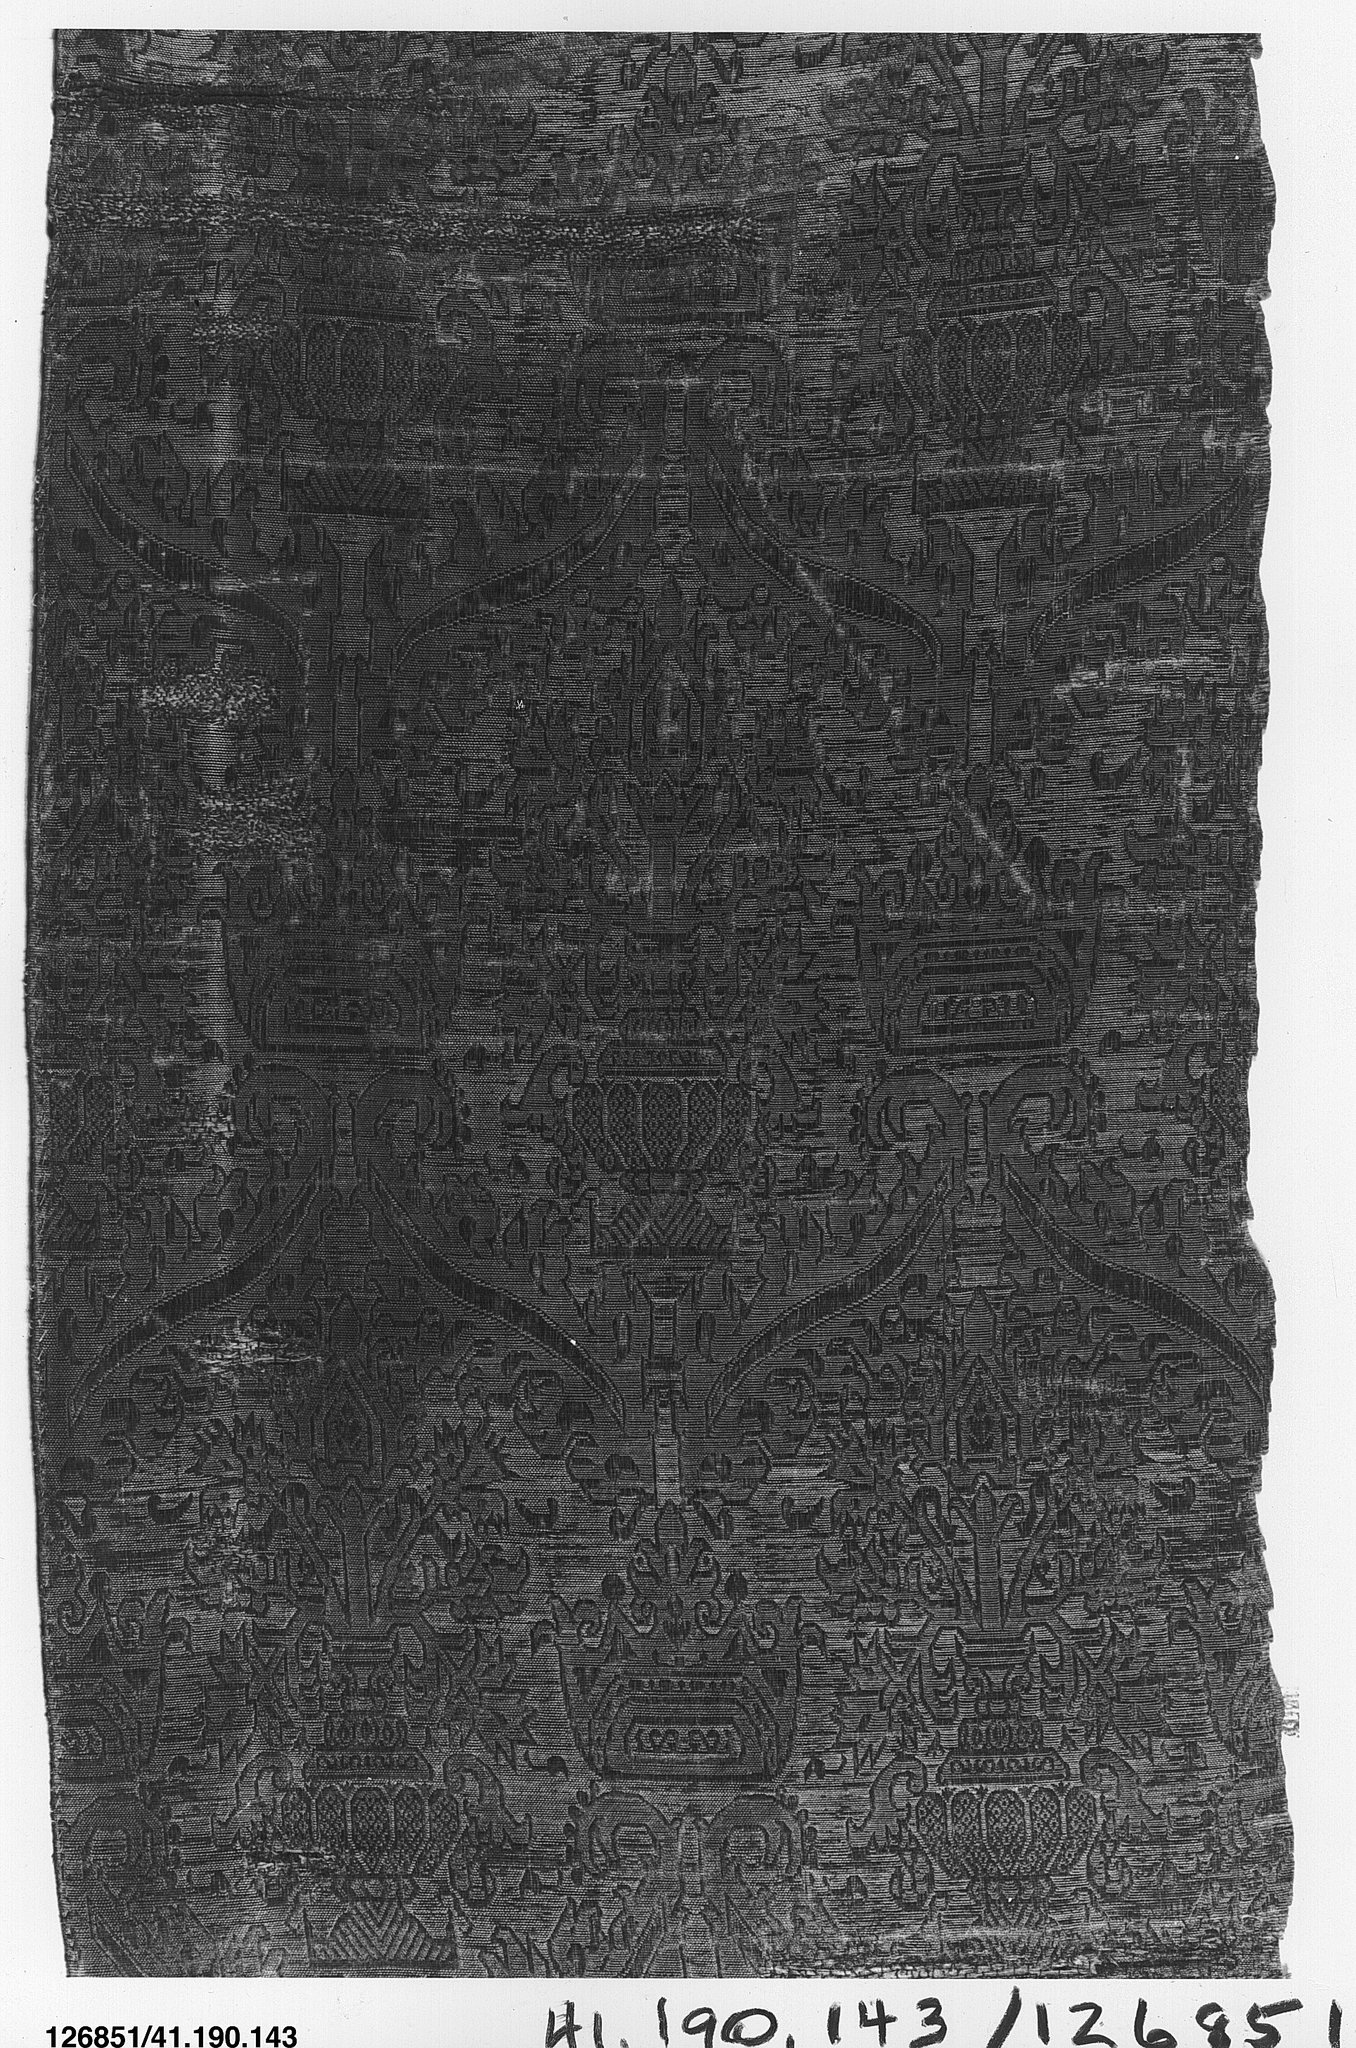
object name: piece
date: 1551-1600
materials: silk